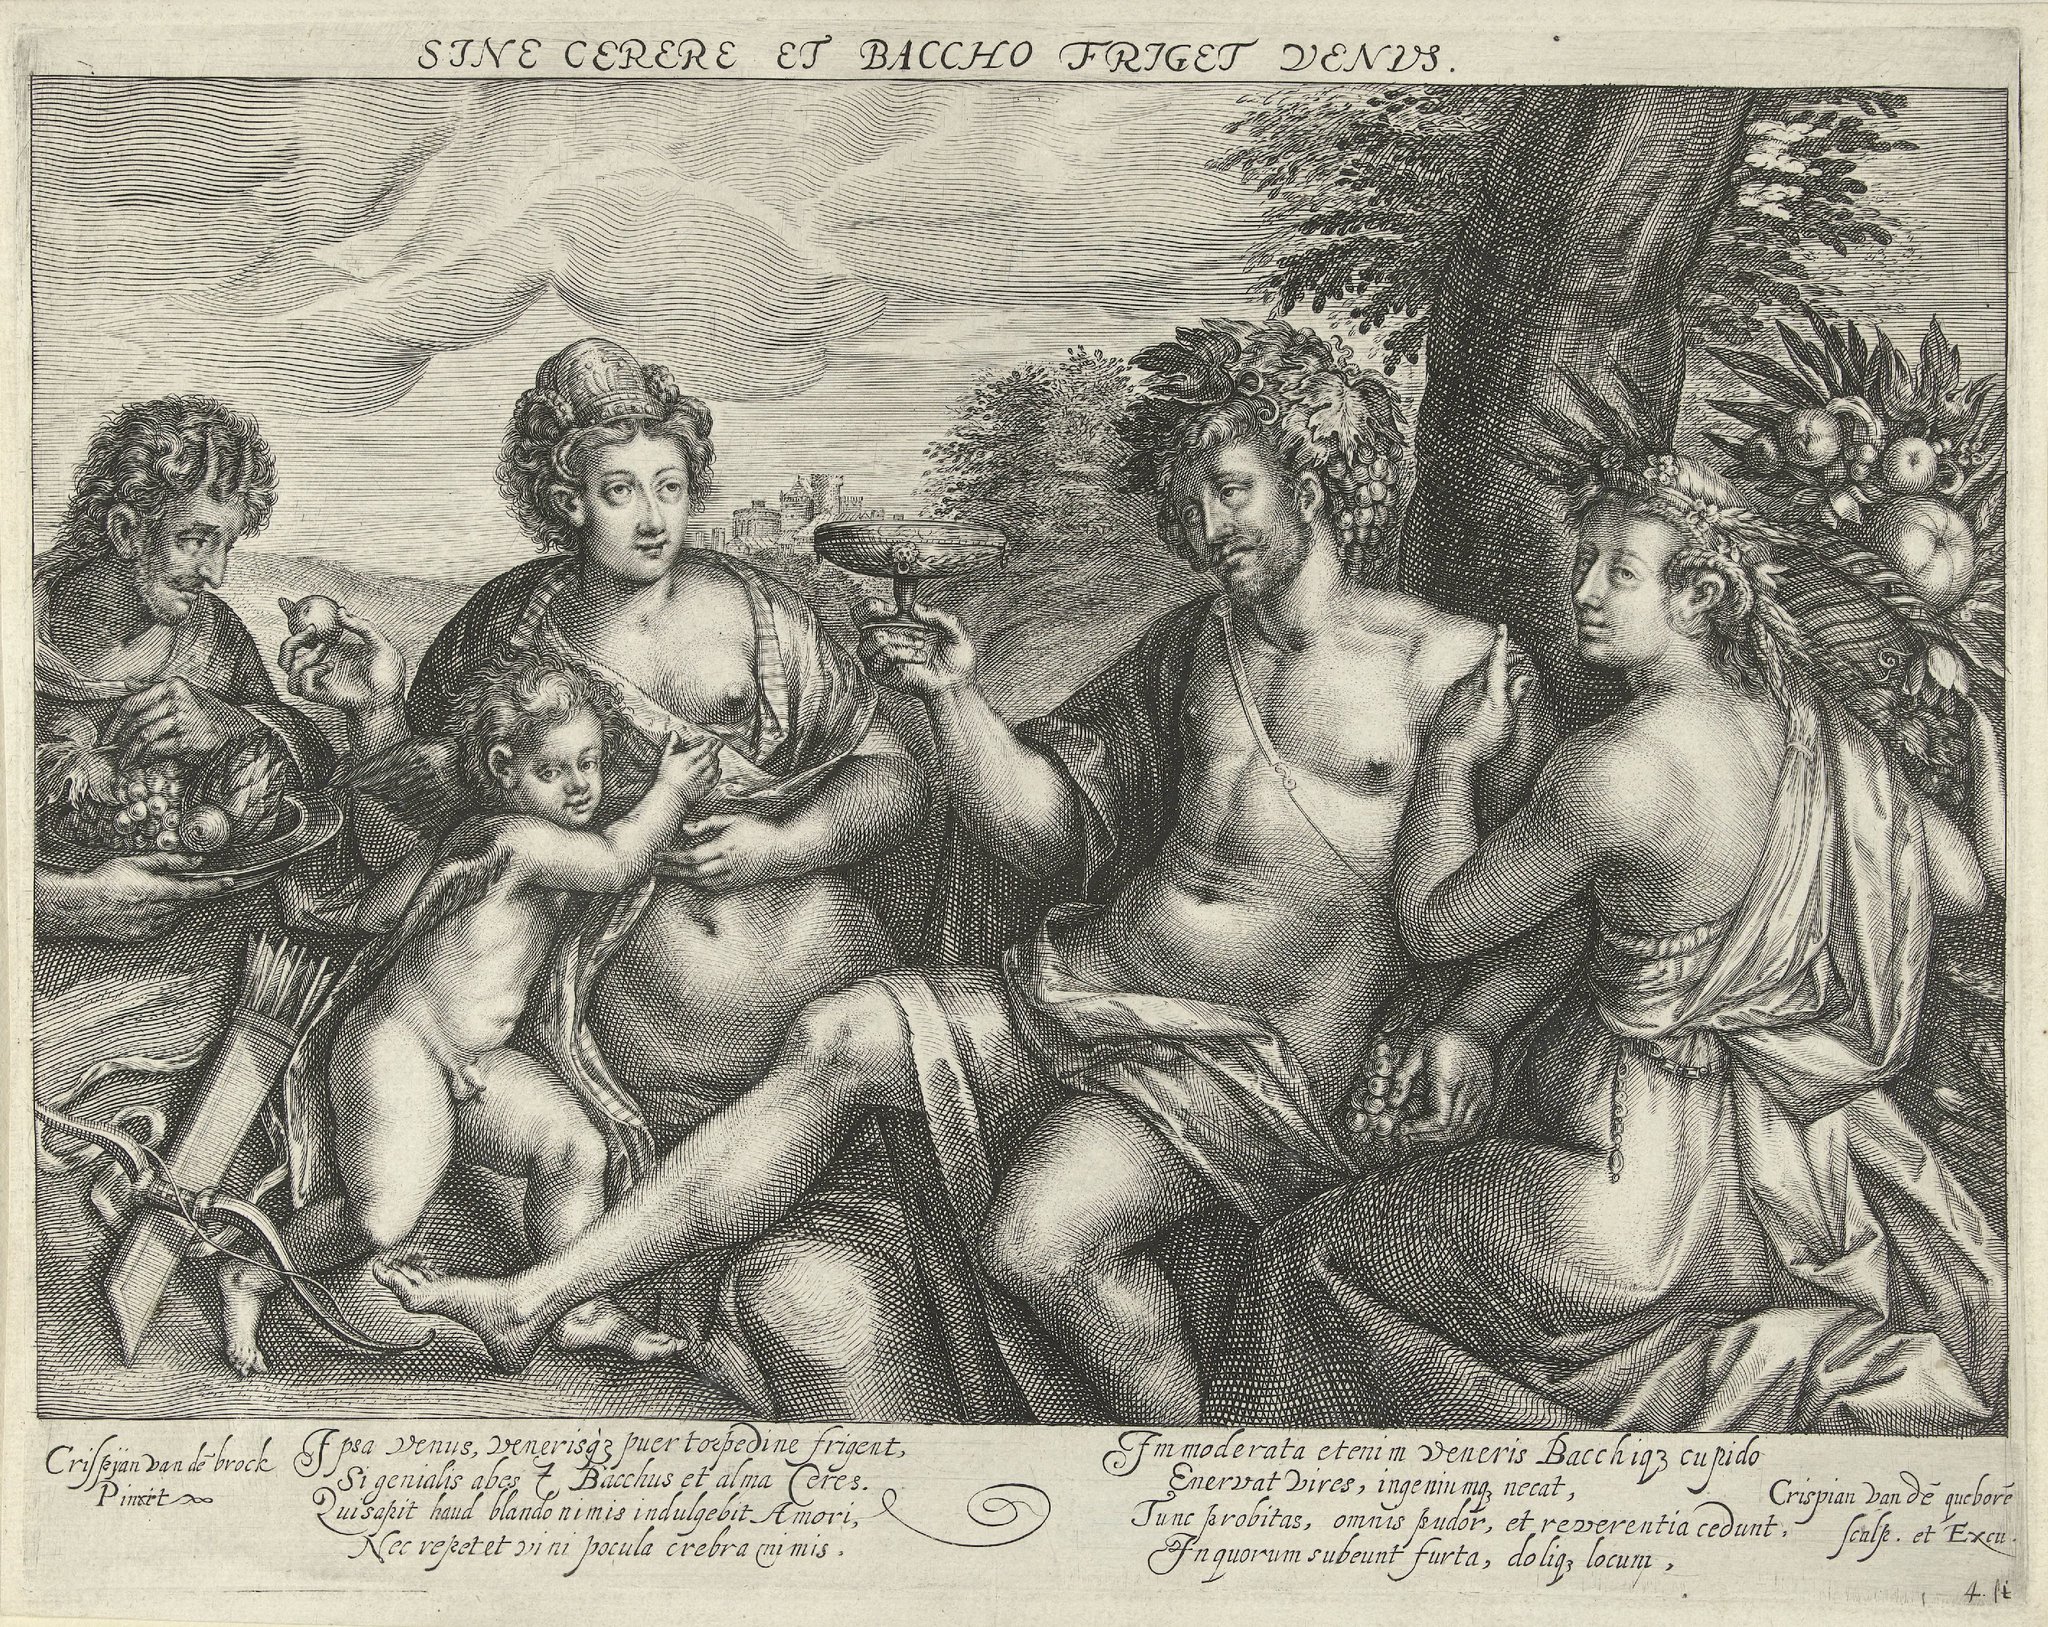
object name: print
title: Bacchus, Venus en Ceres in een landschap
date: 1614-1652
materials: paper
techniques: engraving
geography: the hague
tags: 'sine cerere et baccho friget venus', venus and cupid (cupid not being mere attribute), ceres, patroness of agriculture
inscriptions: collector's mark: Lugt 2228, inscription: ‘4.ft’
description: Tussen Venus (links) en Ceres (rechts) zit Bacchus met een opgeheven drinkschaal in de rechterhand en een tros druiven in de andere. De halfnaakte Venus wordt vergezeld door Amor en een sater die haar vruchten van een schaal aanbiedt. Ceres draagt korenaren in de haren en houdt een grote mand met vruchten op haar schouder. De afbeelding is een illustratie van het gezegde 'Sine Cerere et Baccho friget Venus' (zonder Ceres en Bacchus zou Venus bevriezen). Ofwel zonder eten en wijn bevriest de liefde.